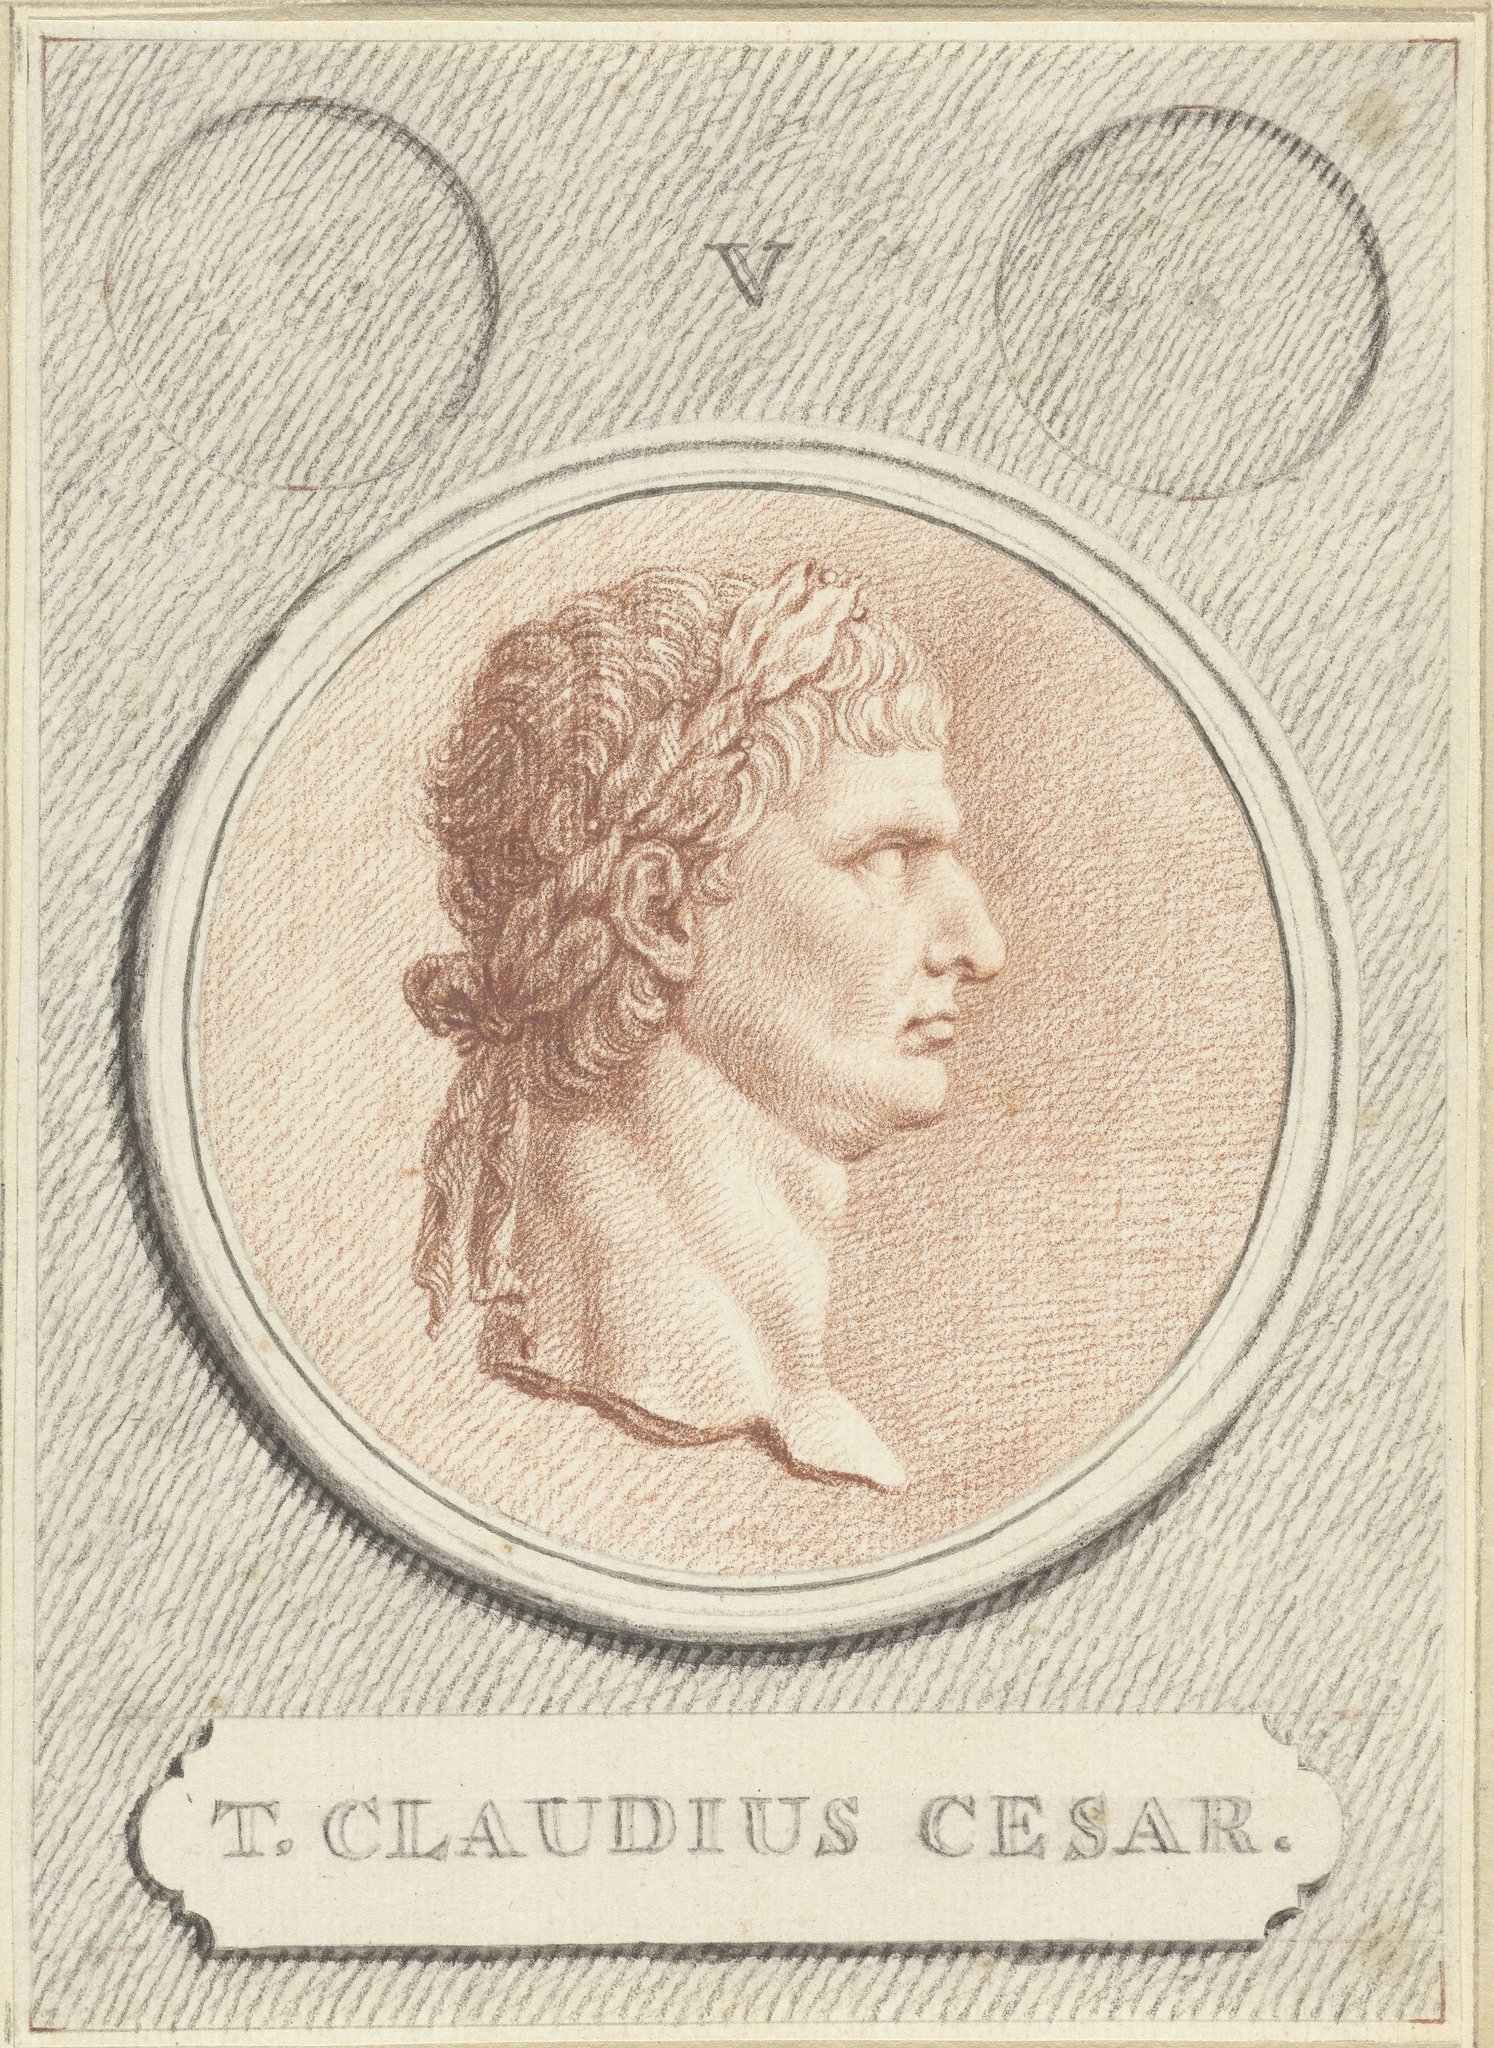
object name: design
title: Portretmedaillon van Claudius I, Romeins keizer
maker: jan caspar philips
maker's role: draughtsman, print maker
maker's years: 1700-1775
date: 1736-1775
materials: chalk, ink, paper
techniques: brush, pen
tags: (story of) claudius the roman emperor - portrait of person from classical history, historical persons